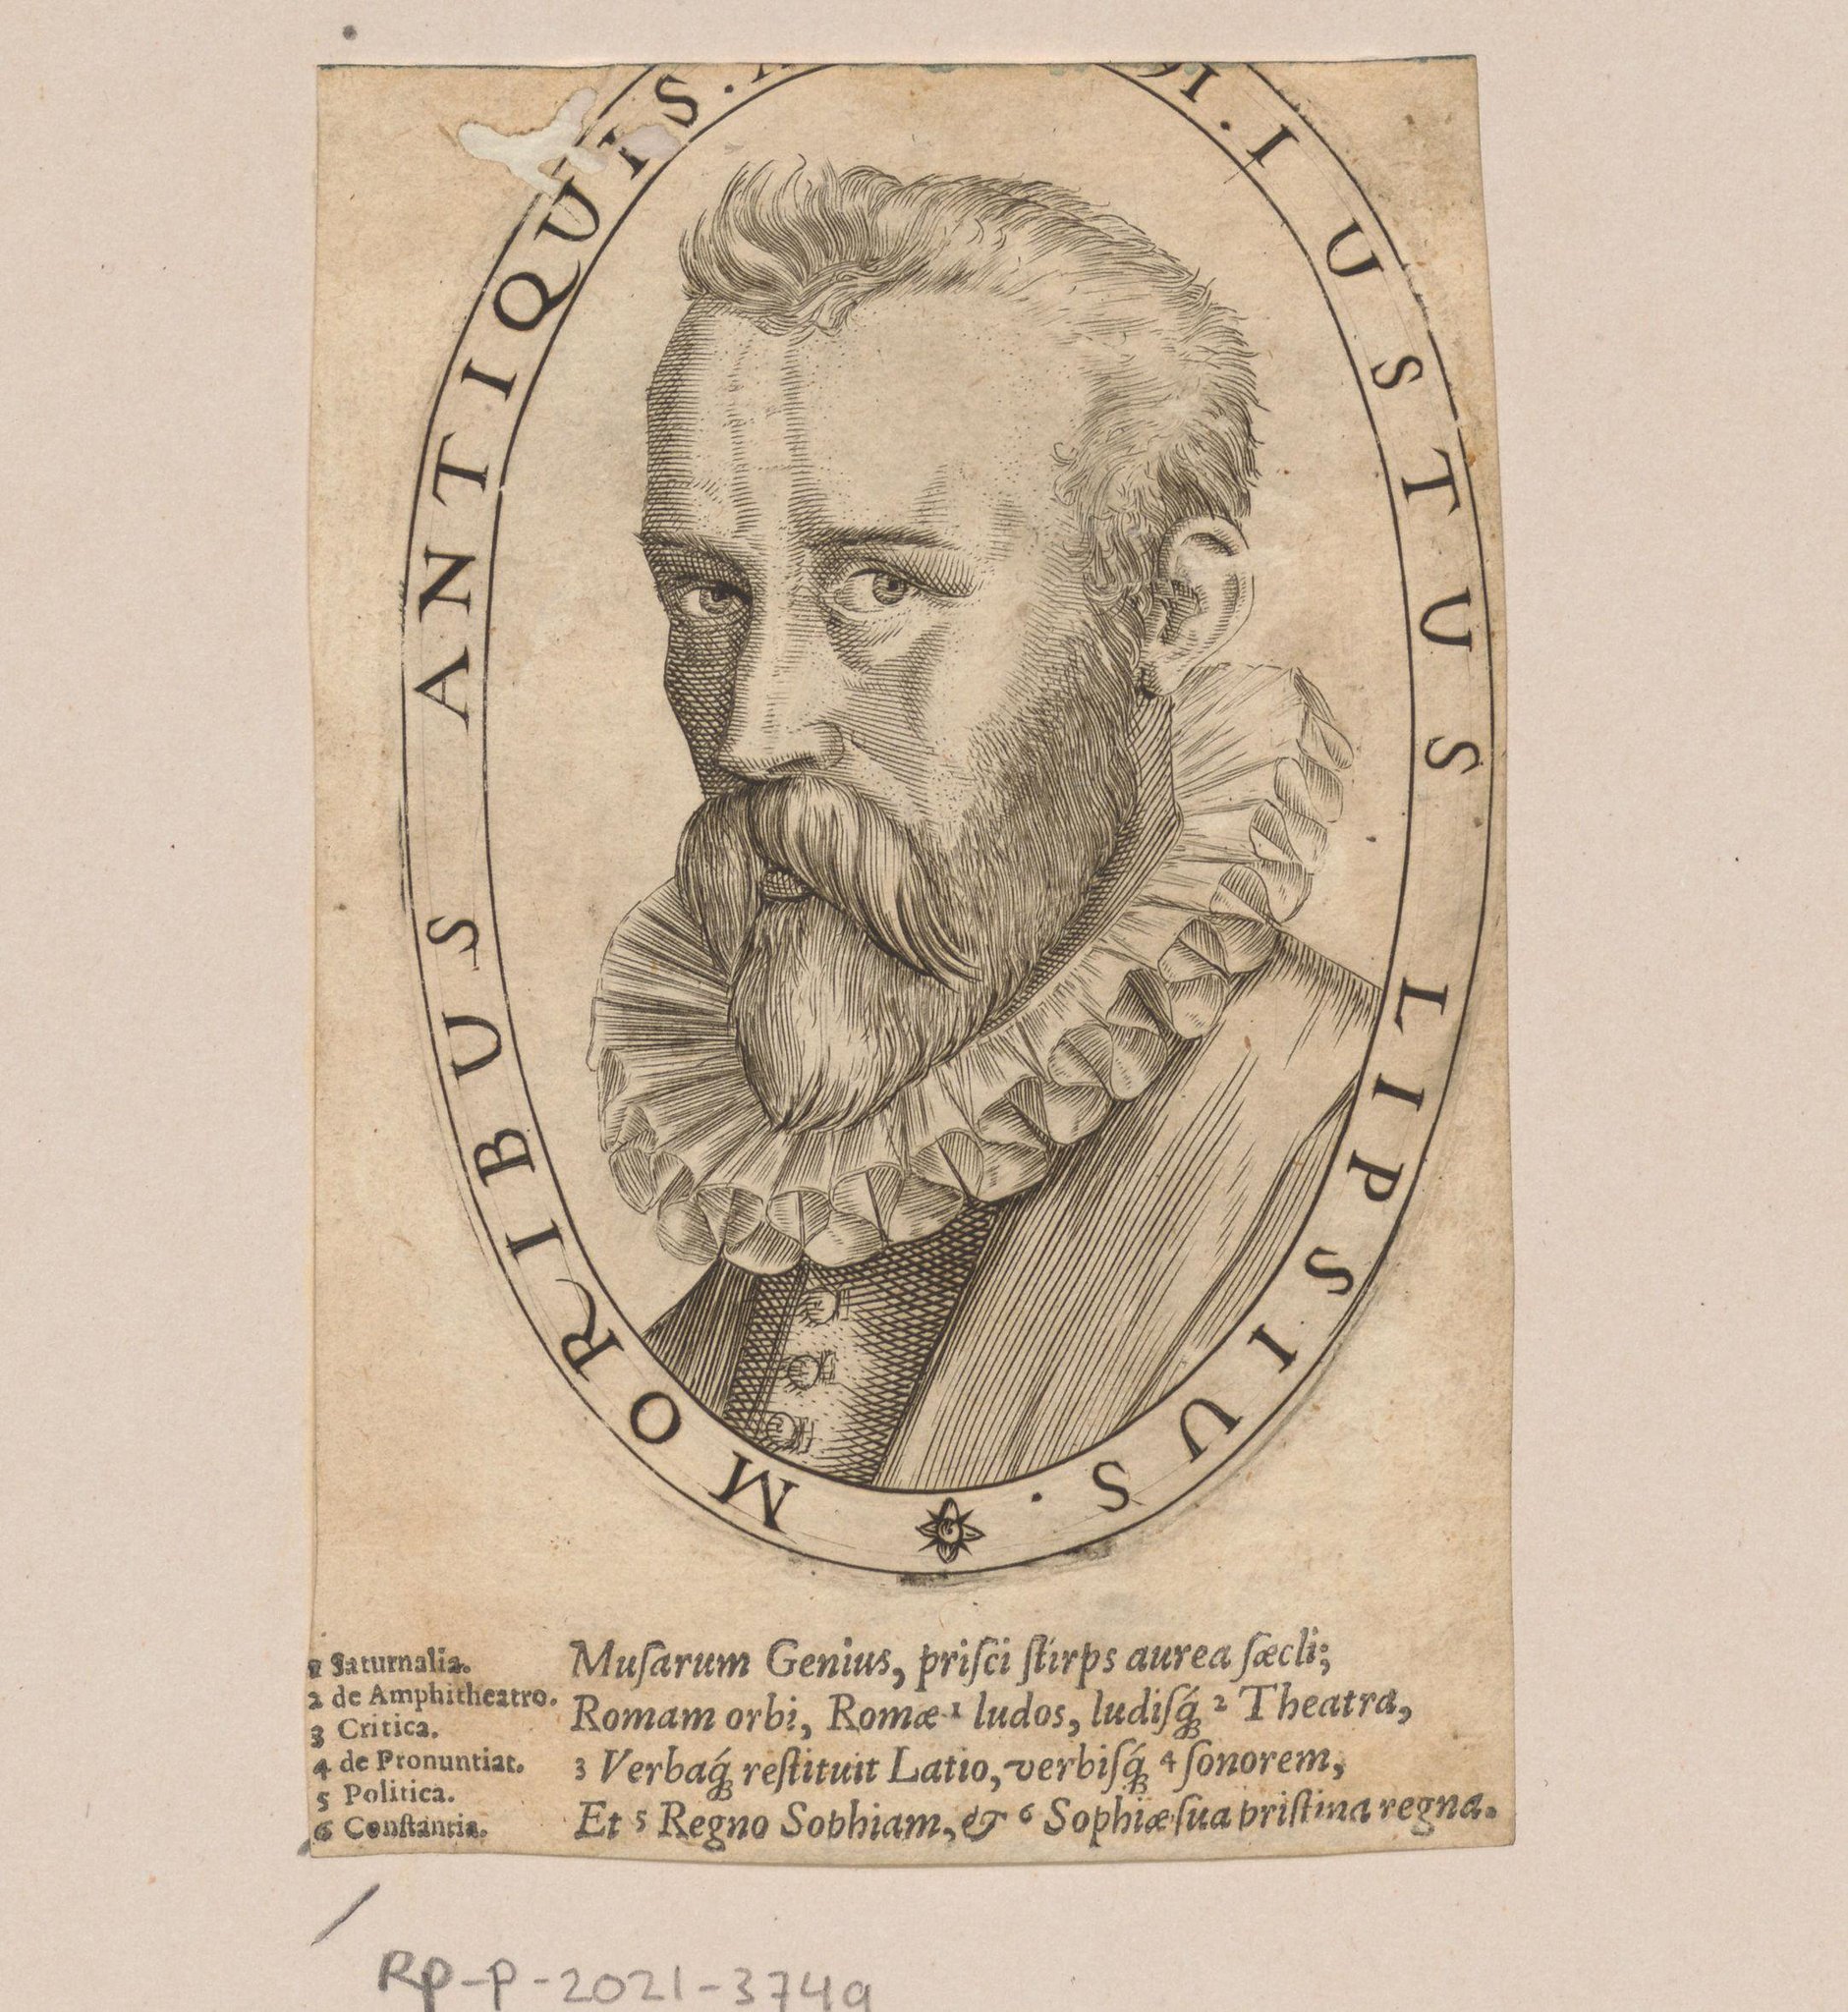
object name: print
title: Portret van Justus Lipsius op 43-jarige leeftijd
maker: Anonymous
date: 1591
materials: paper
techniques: engraving, letterpress printing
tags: louvain, justus lipsius, ornament ~ medallion, historical persons, portrait of a writer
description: Met vierregelig vers in het Latijn onder het portret.